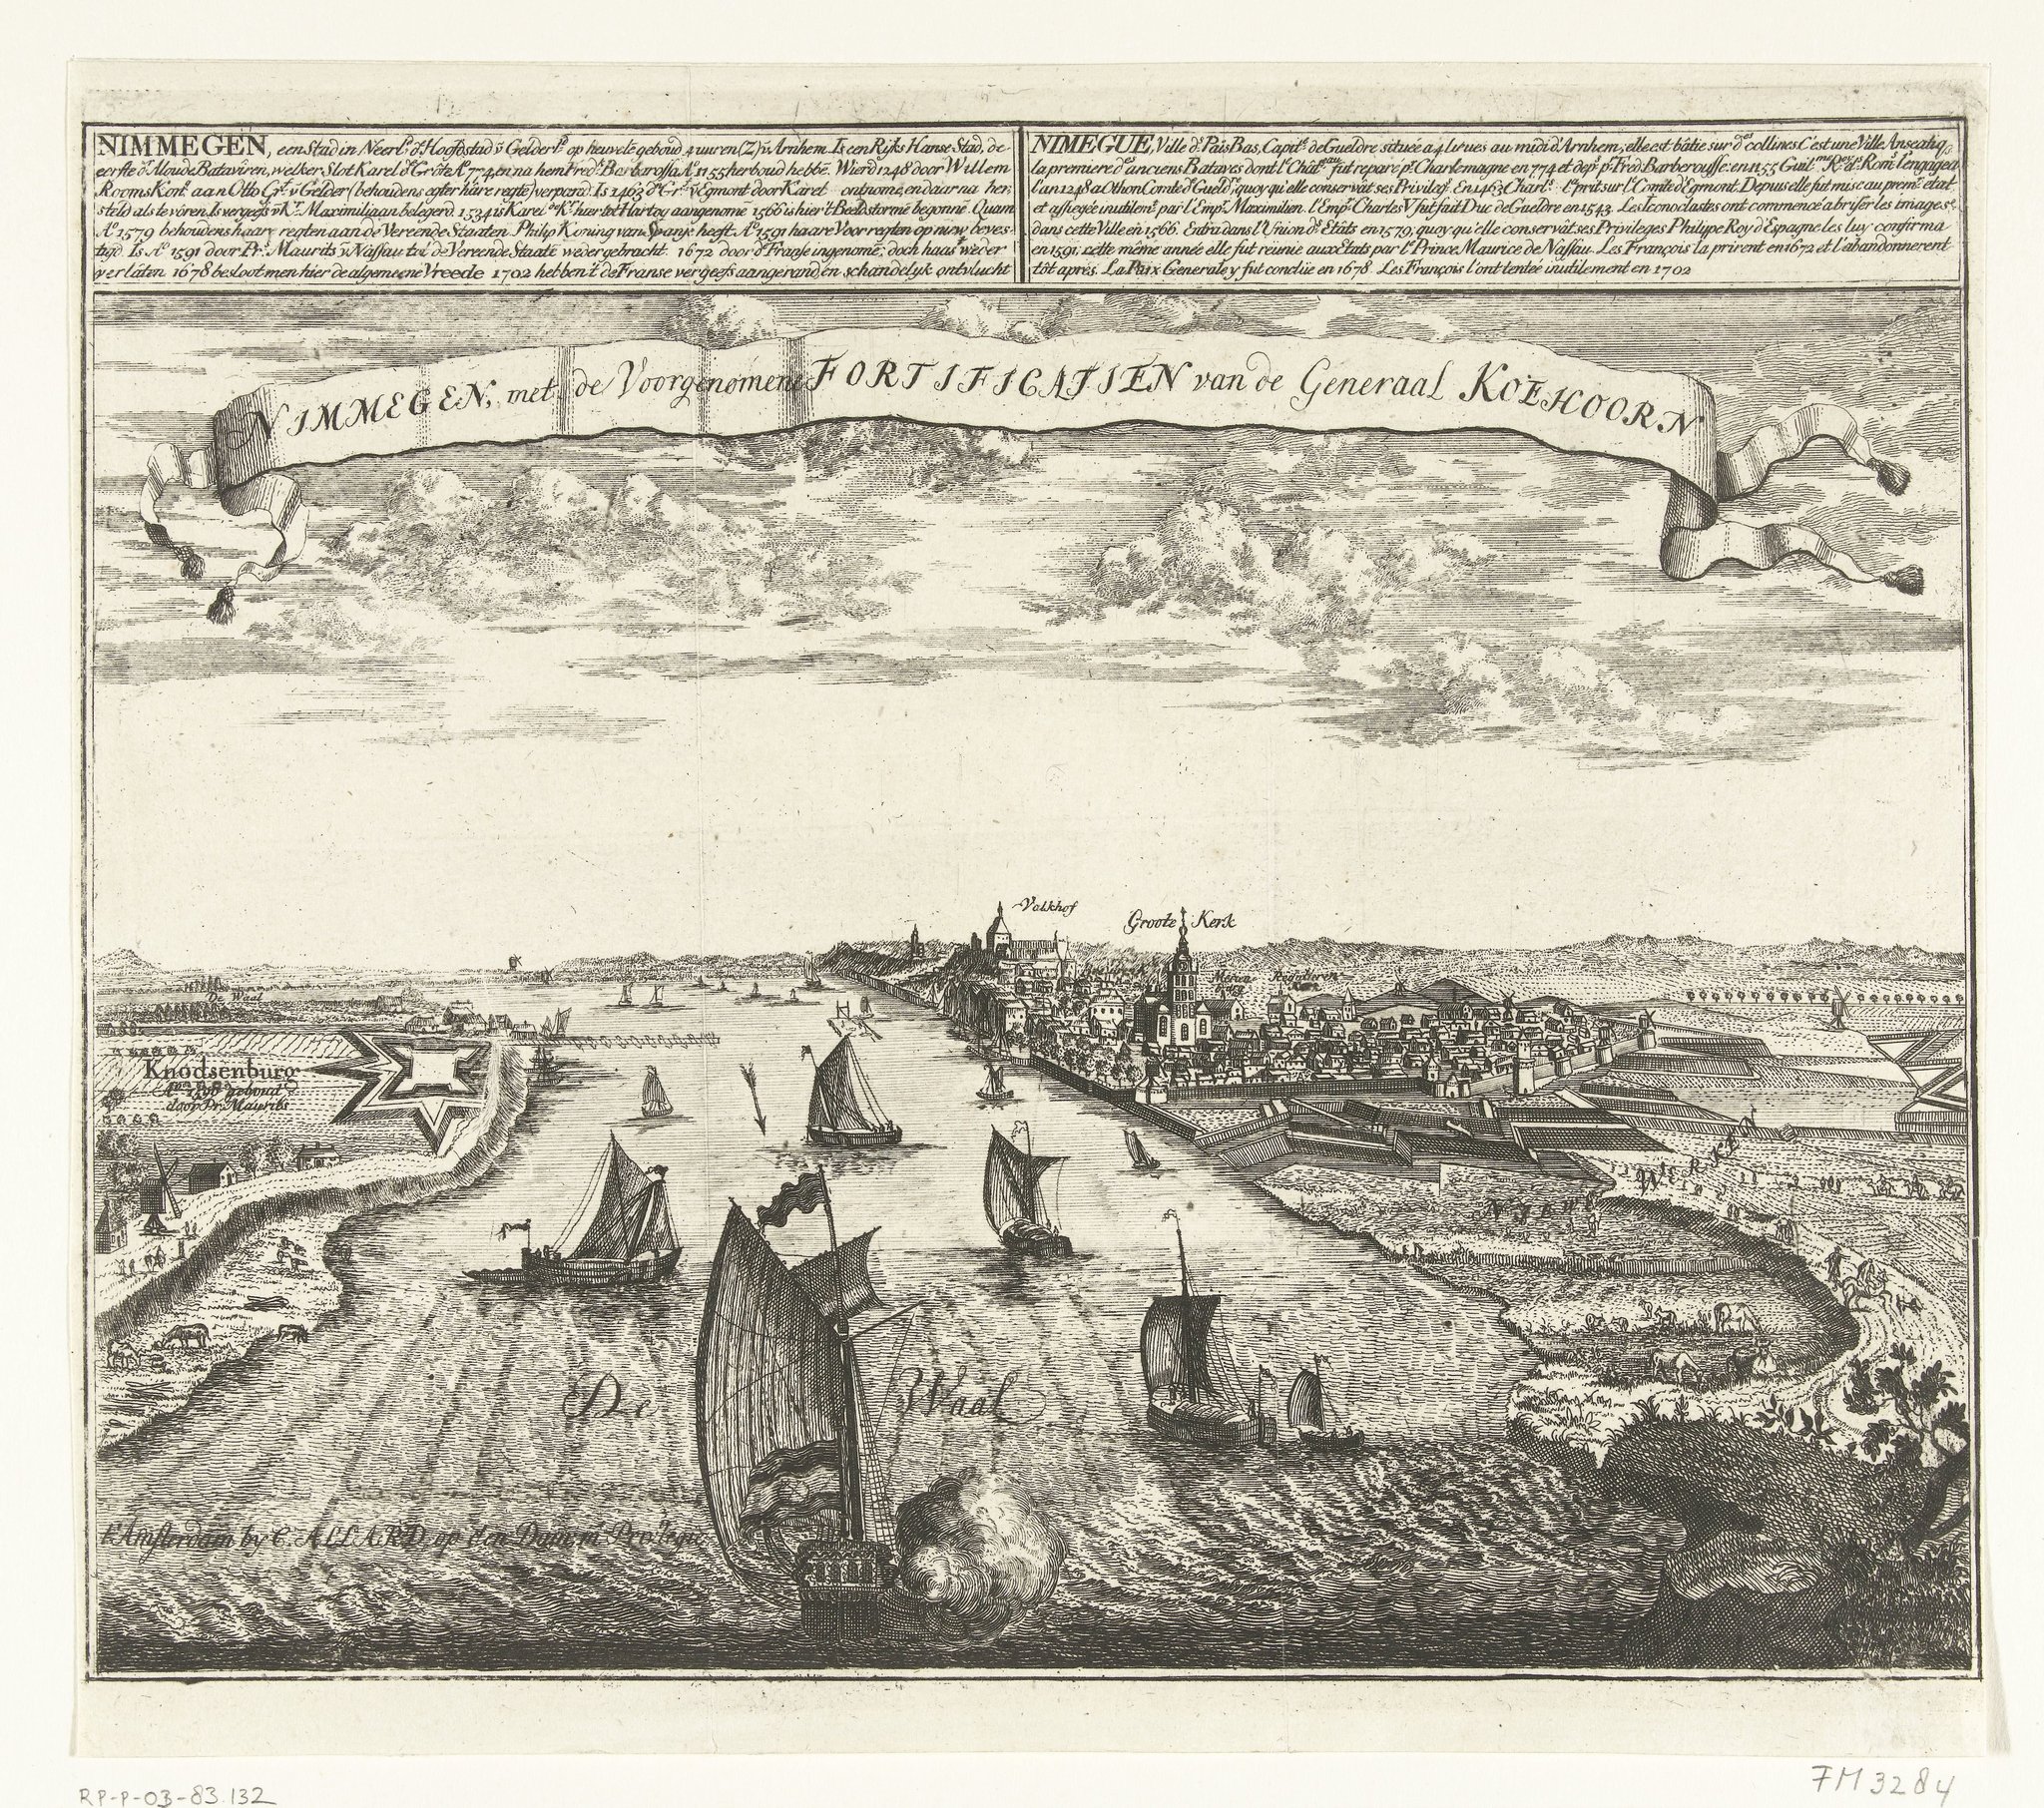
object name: print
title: Nimmegen, met de Voorgenomene Fortificatien van de Generaal Koehoorn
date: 1702-1705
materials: paper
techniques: etching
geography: amsterdam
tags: the hague, fortress, nijmegen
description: Gezicht op Nijmegen aan de Waal met de geplande nieuwe fortificaties ontworpen door Menno baron van Coehoorn, 1702. Bovenaan teksten in het Nederlands en Frans met vermelding van de mislukte aanval door de Fransen in 1702.